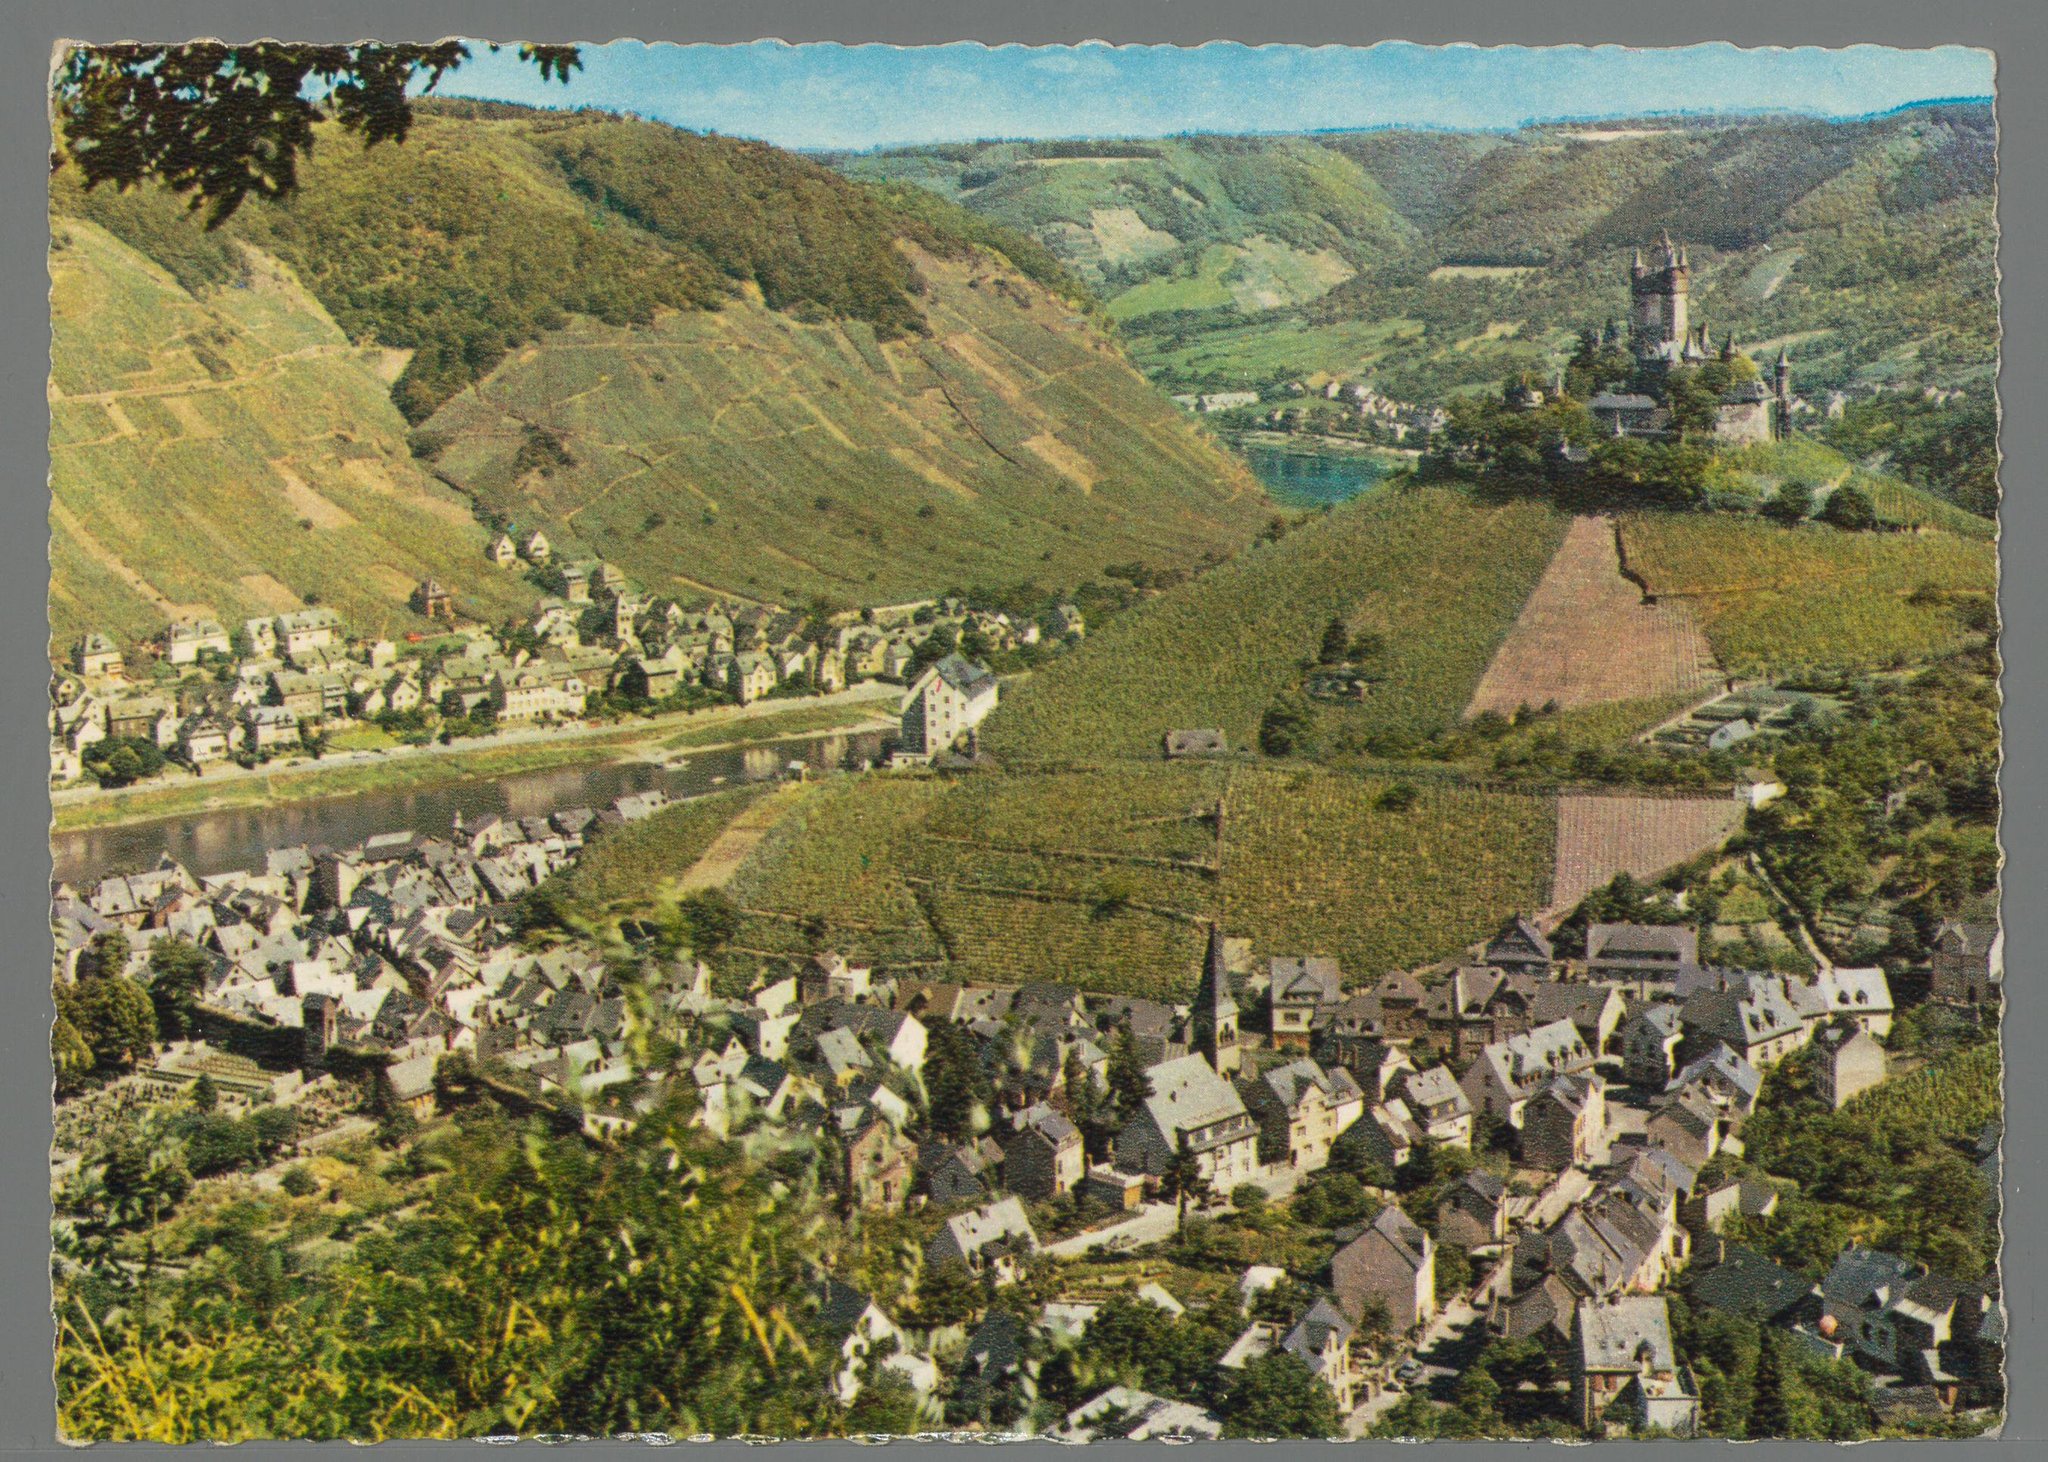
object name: ansichtkaart, prentbriefkaart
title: Cochem an der Mosel. Blick auf die Burg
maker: Anonymous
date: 1960-2000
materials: cardboard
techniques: four-color rotogravure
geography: cochem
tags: city-view, and landscape with man-made constructions, castle